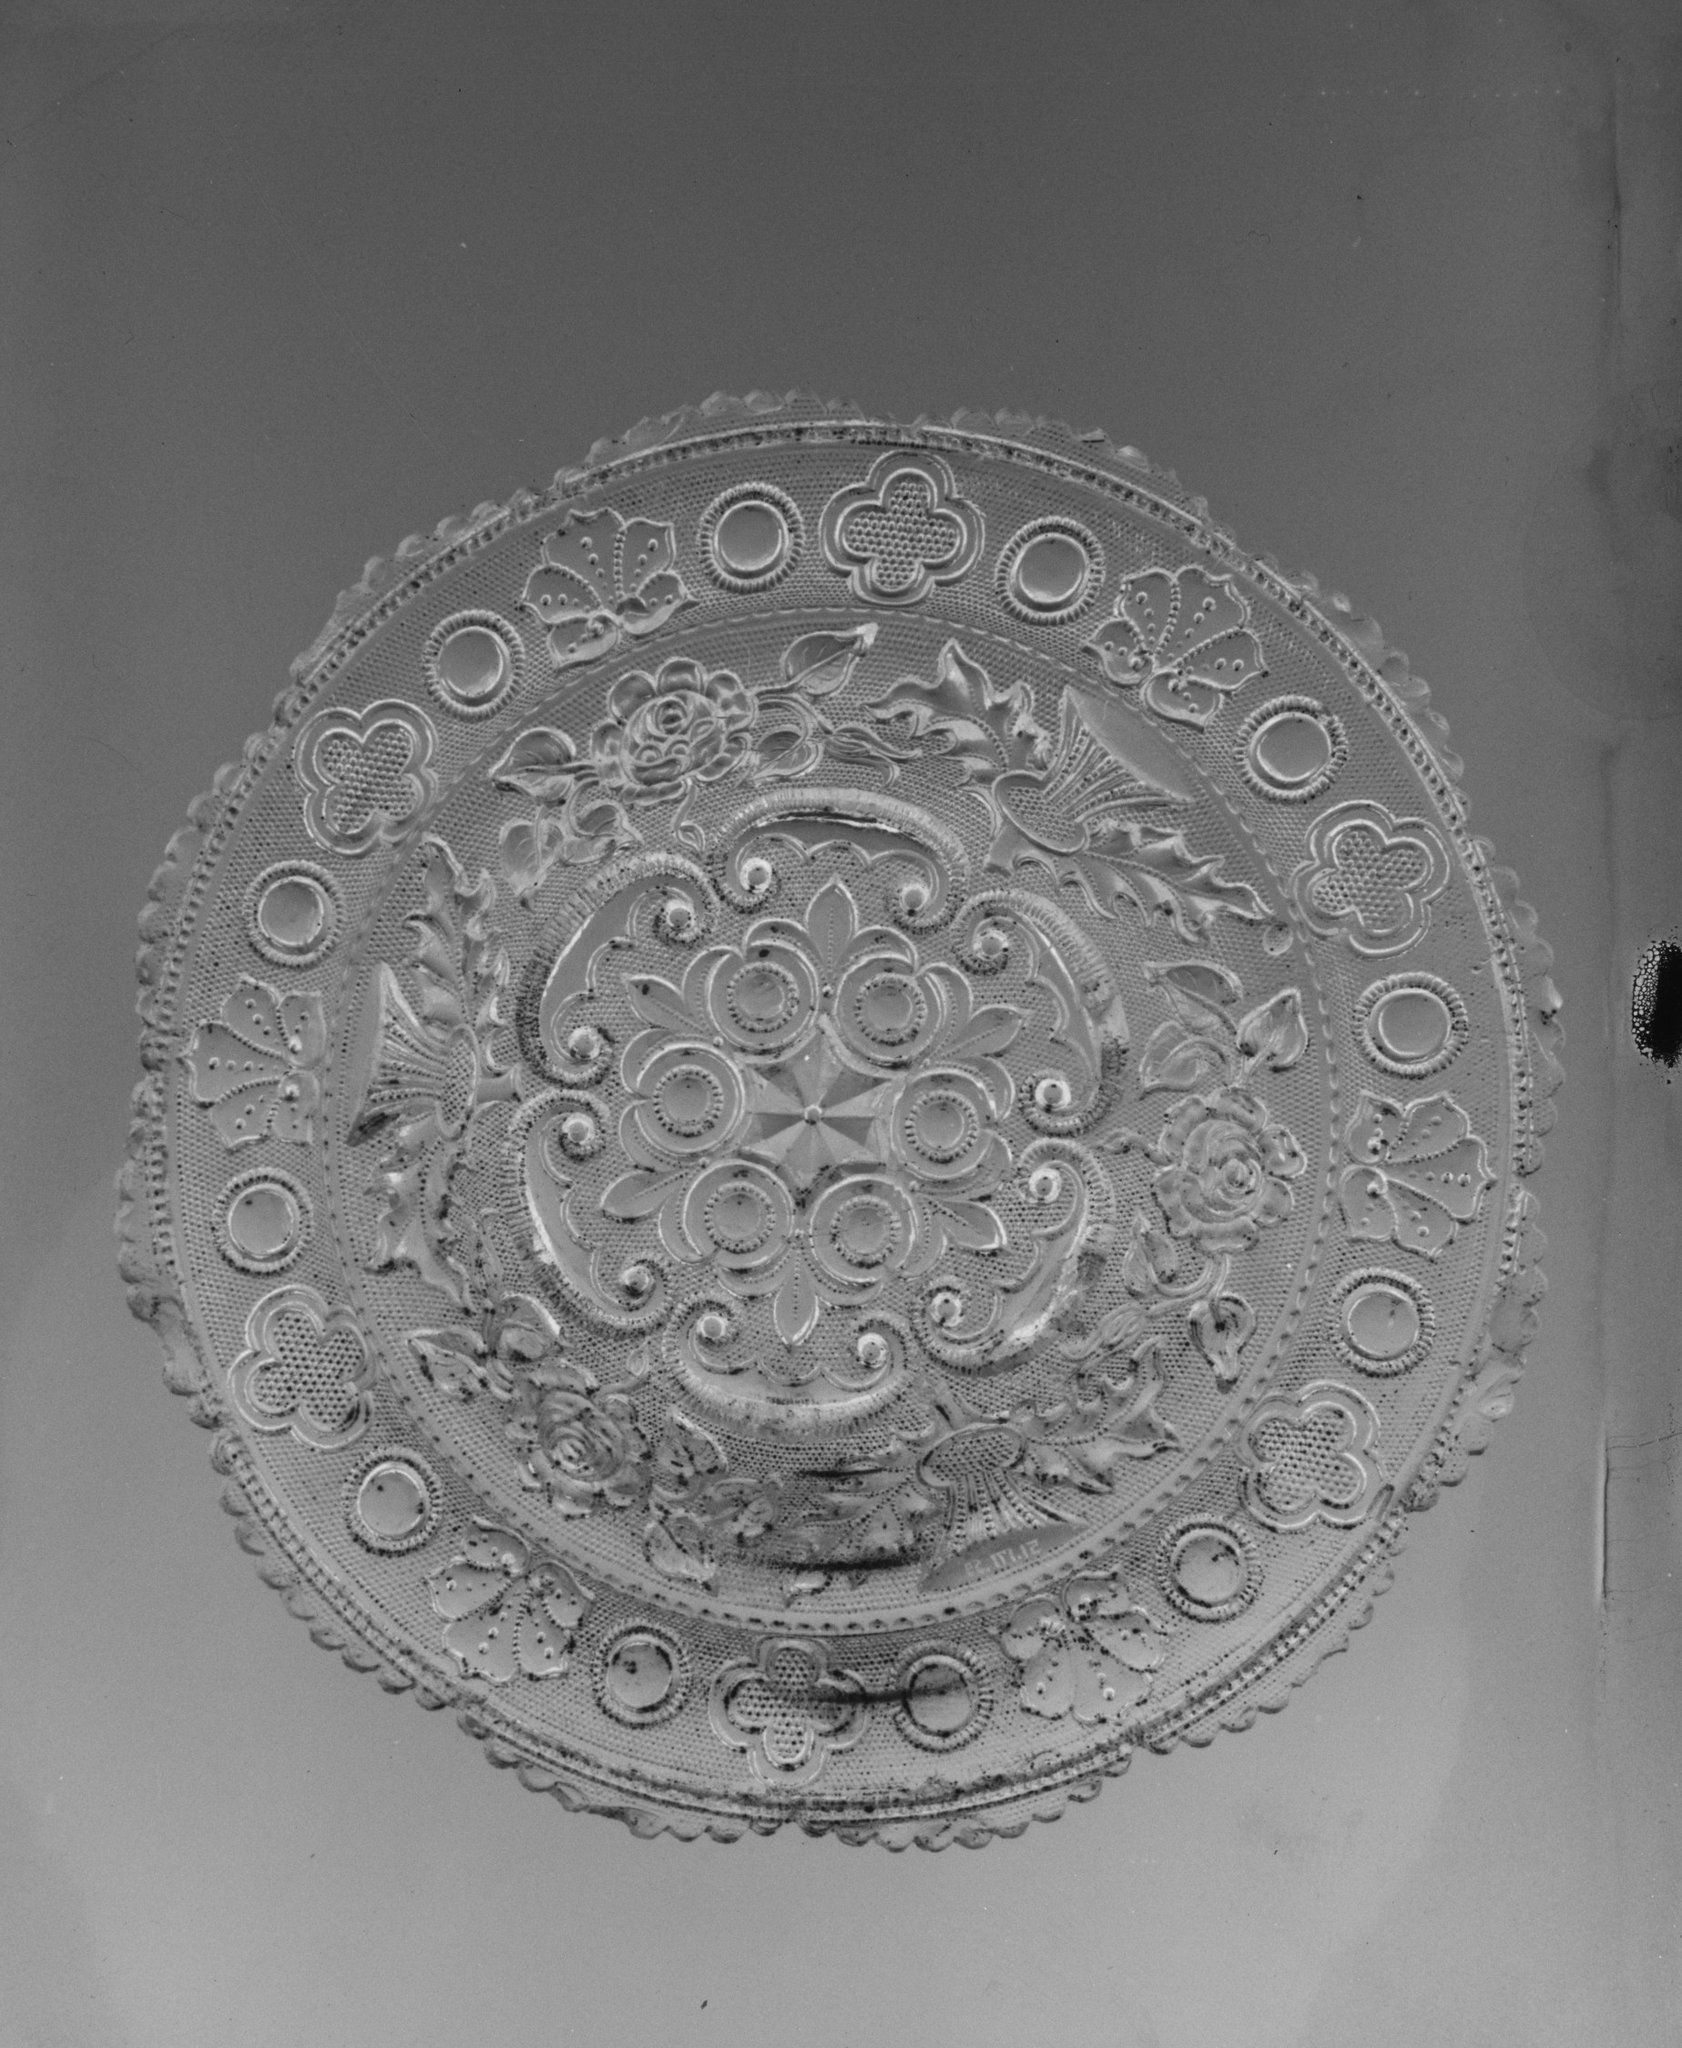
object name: bowl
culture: american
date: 1835-1850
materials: glass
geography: united states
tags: flowers